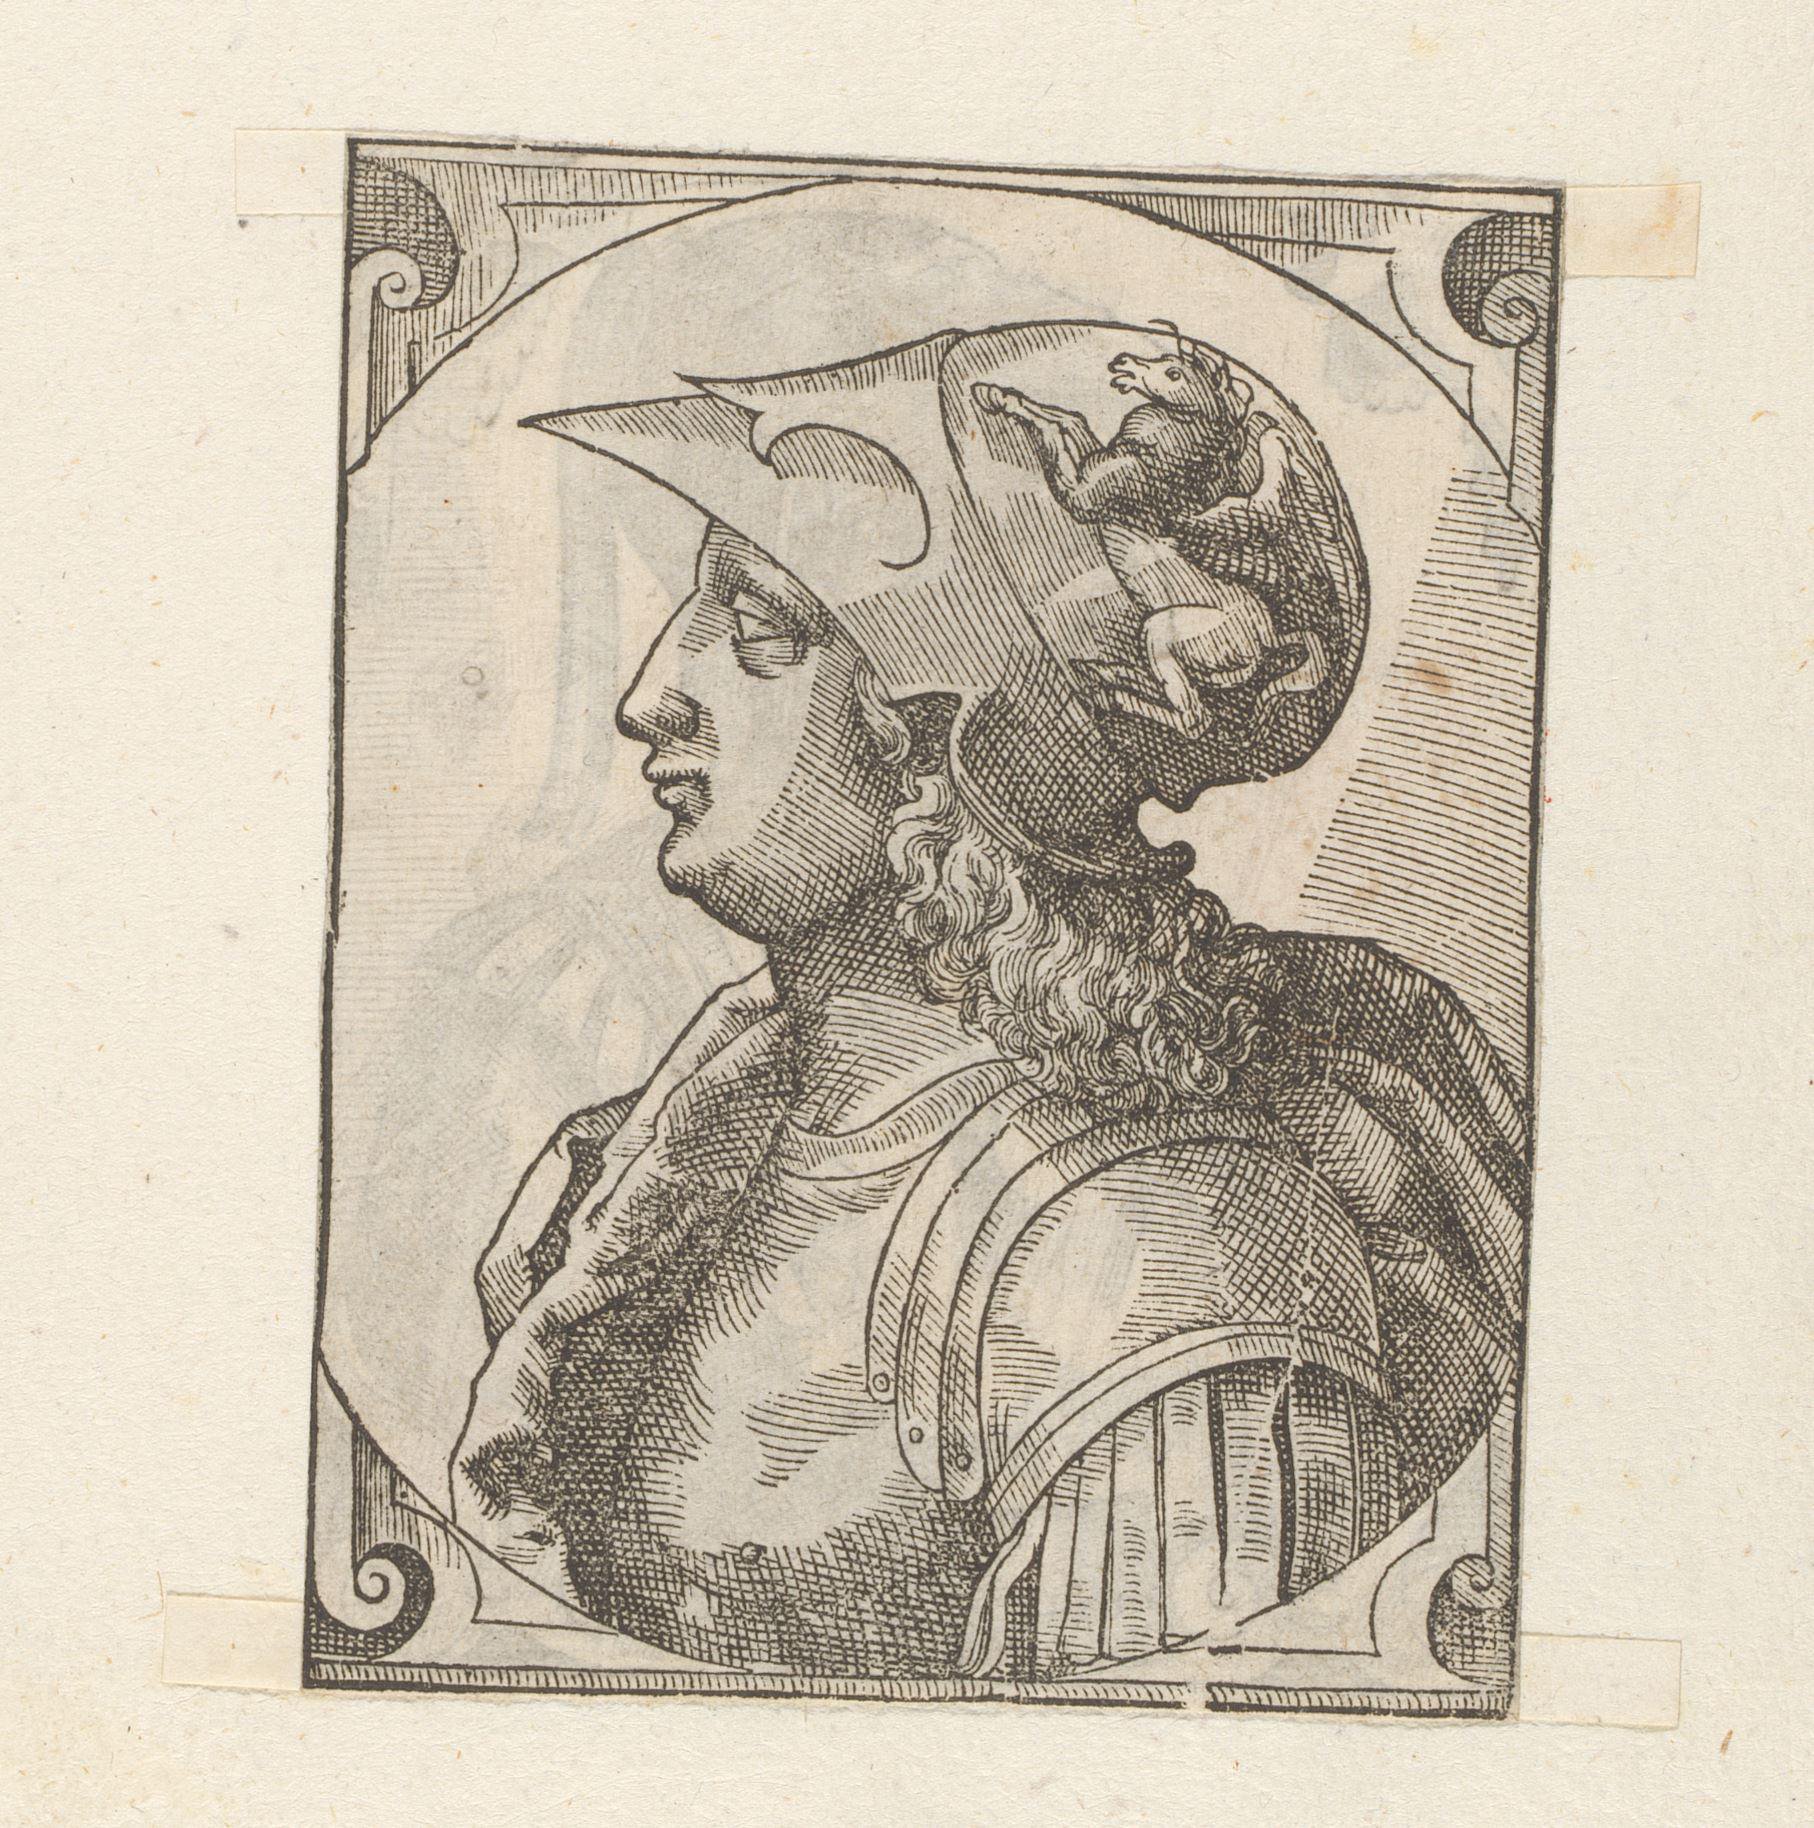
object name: print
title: Portret van Alexander de Grote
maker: Anonymous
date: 1549-1575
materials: paper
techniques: woodcut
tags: historical persons, ruler, sovereign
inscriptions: collector's mark: Lugt 240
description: Prent gebruikt in: Giovio, Paolo. Elogia Virorum bellica virtute illustrium (...). Bazel: Peter Perna, 1575.